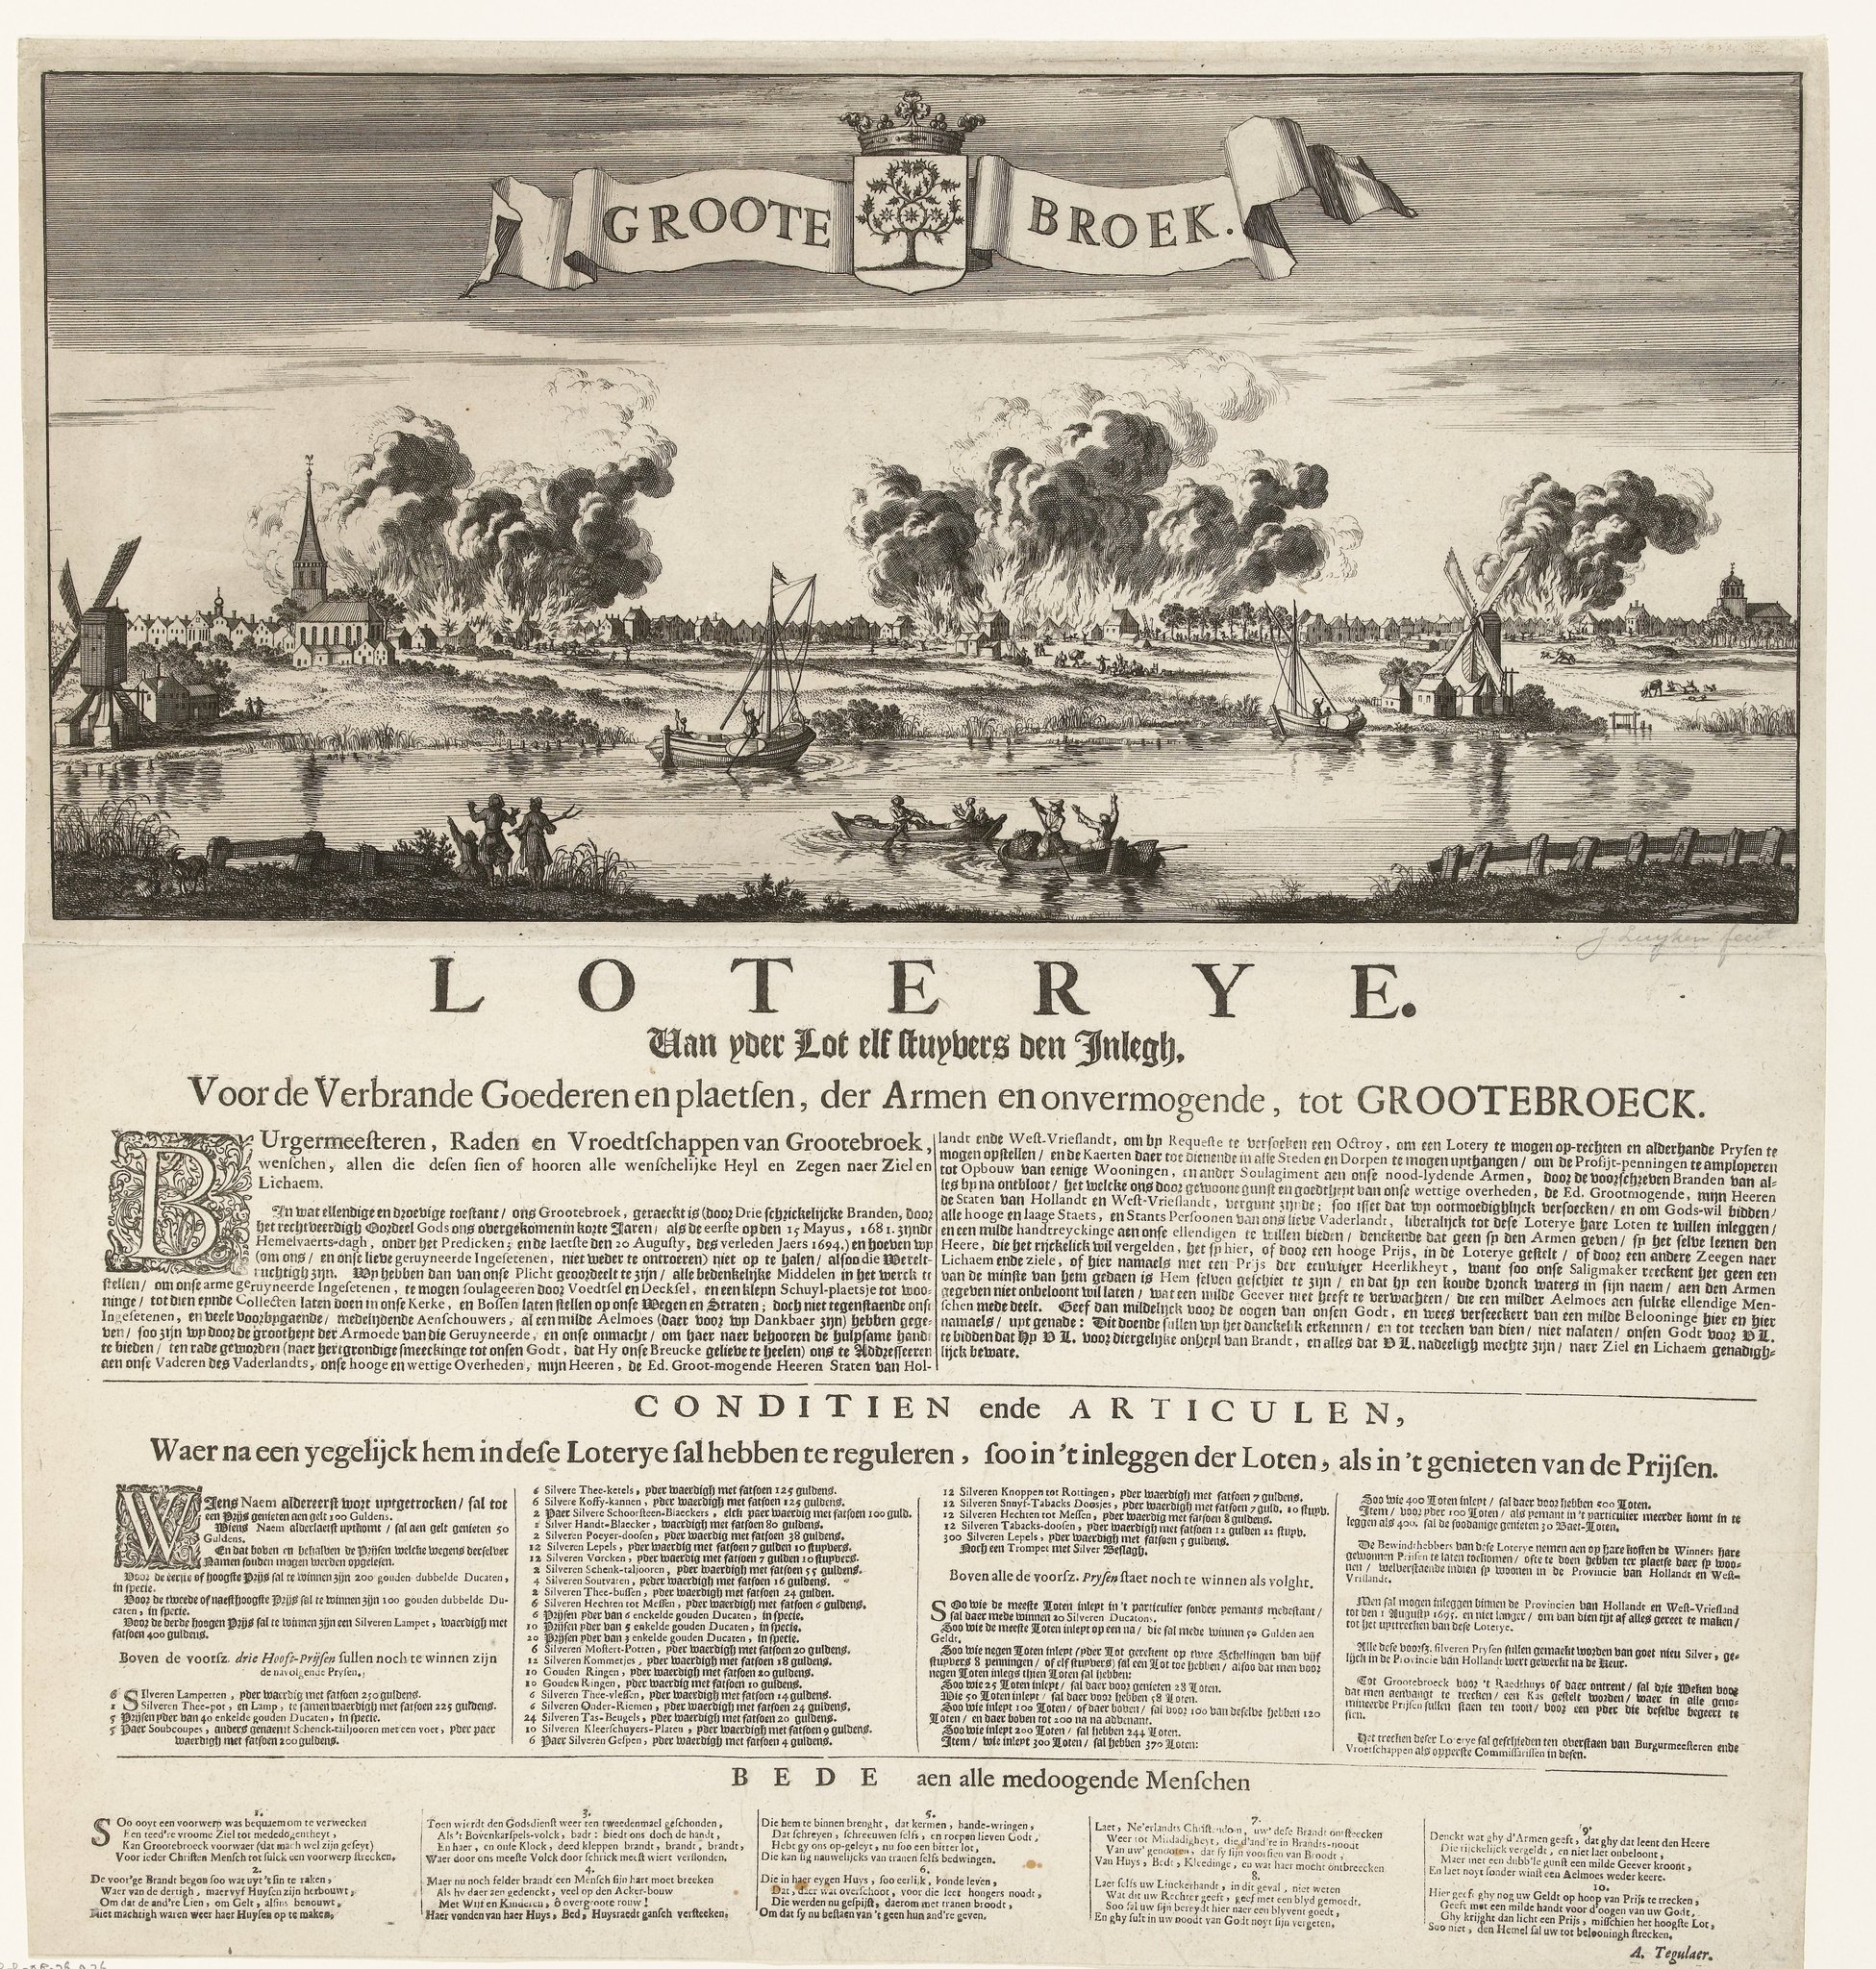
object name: loterijprent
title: Loterij van Grootebroek, 1694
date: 1694-1695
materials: paper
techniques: etching, letterpress printing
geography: northern netherlands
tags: fire-fighting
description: Loterijprent voor de loterij gehouden voor de slachtoffers van de grote brand in het dorp Grootebroek (bij Enkhuizen) op 20 augustus 1694. Bovenaan een voorstelling van de brand met daaronder de bijzonderheden en artikelen van de loterij en een oproep om deel te nemen aan de loterij.